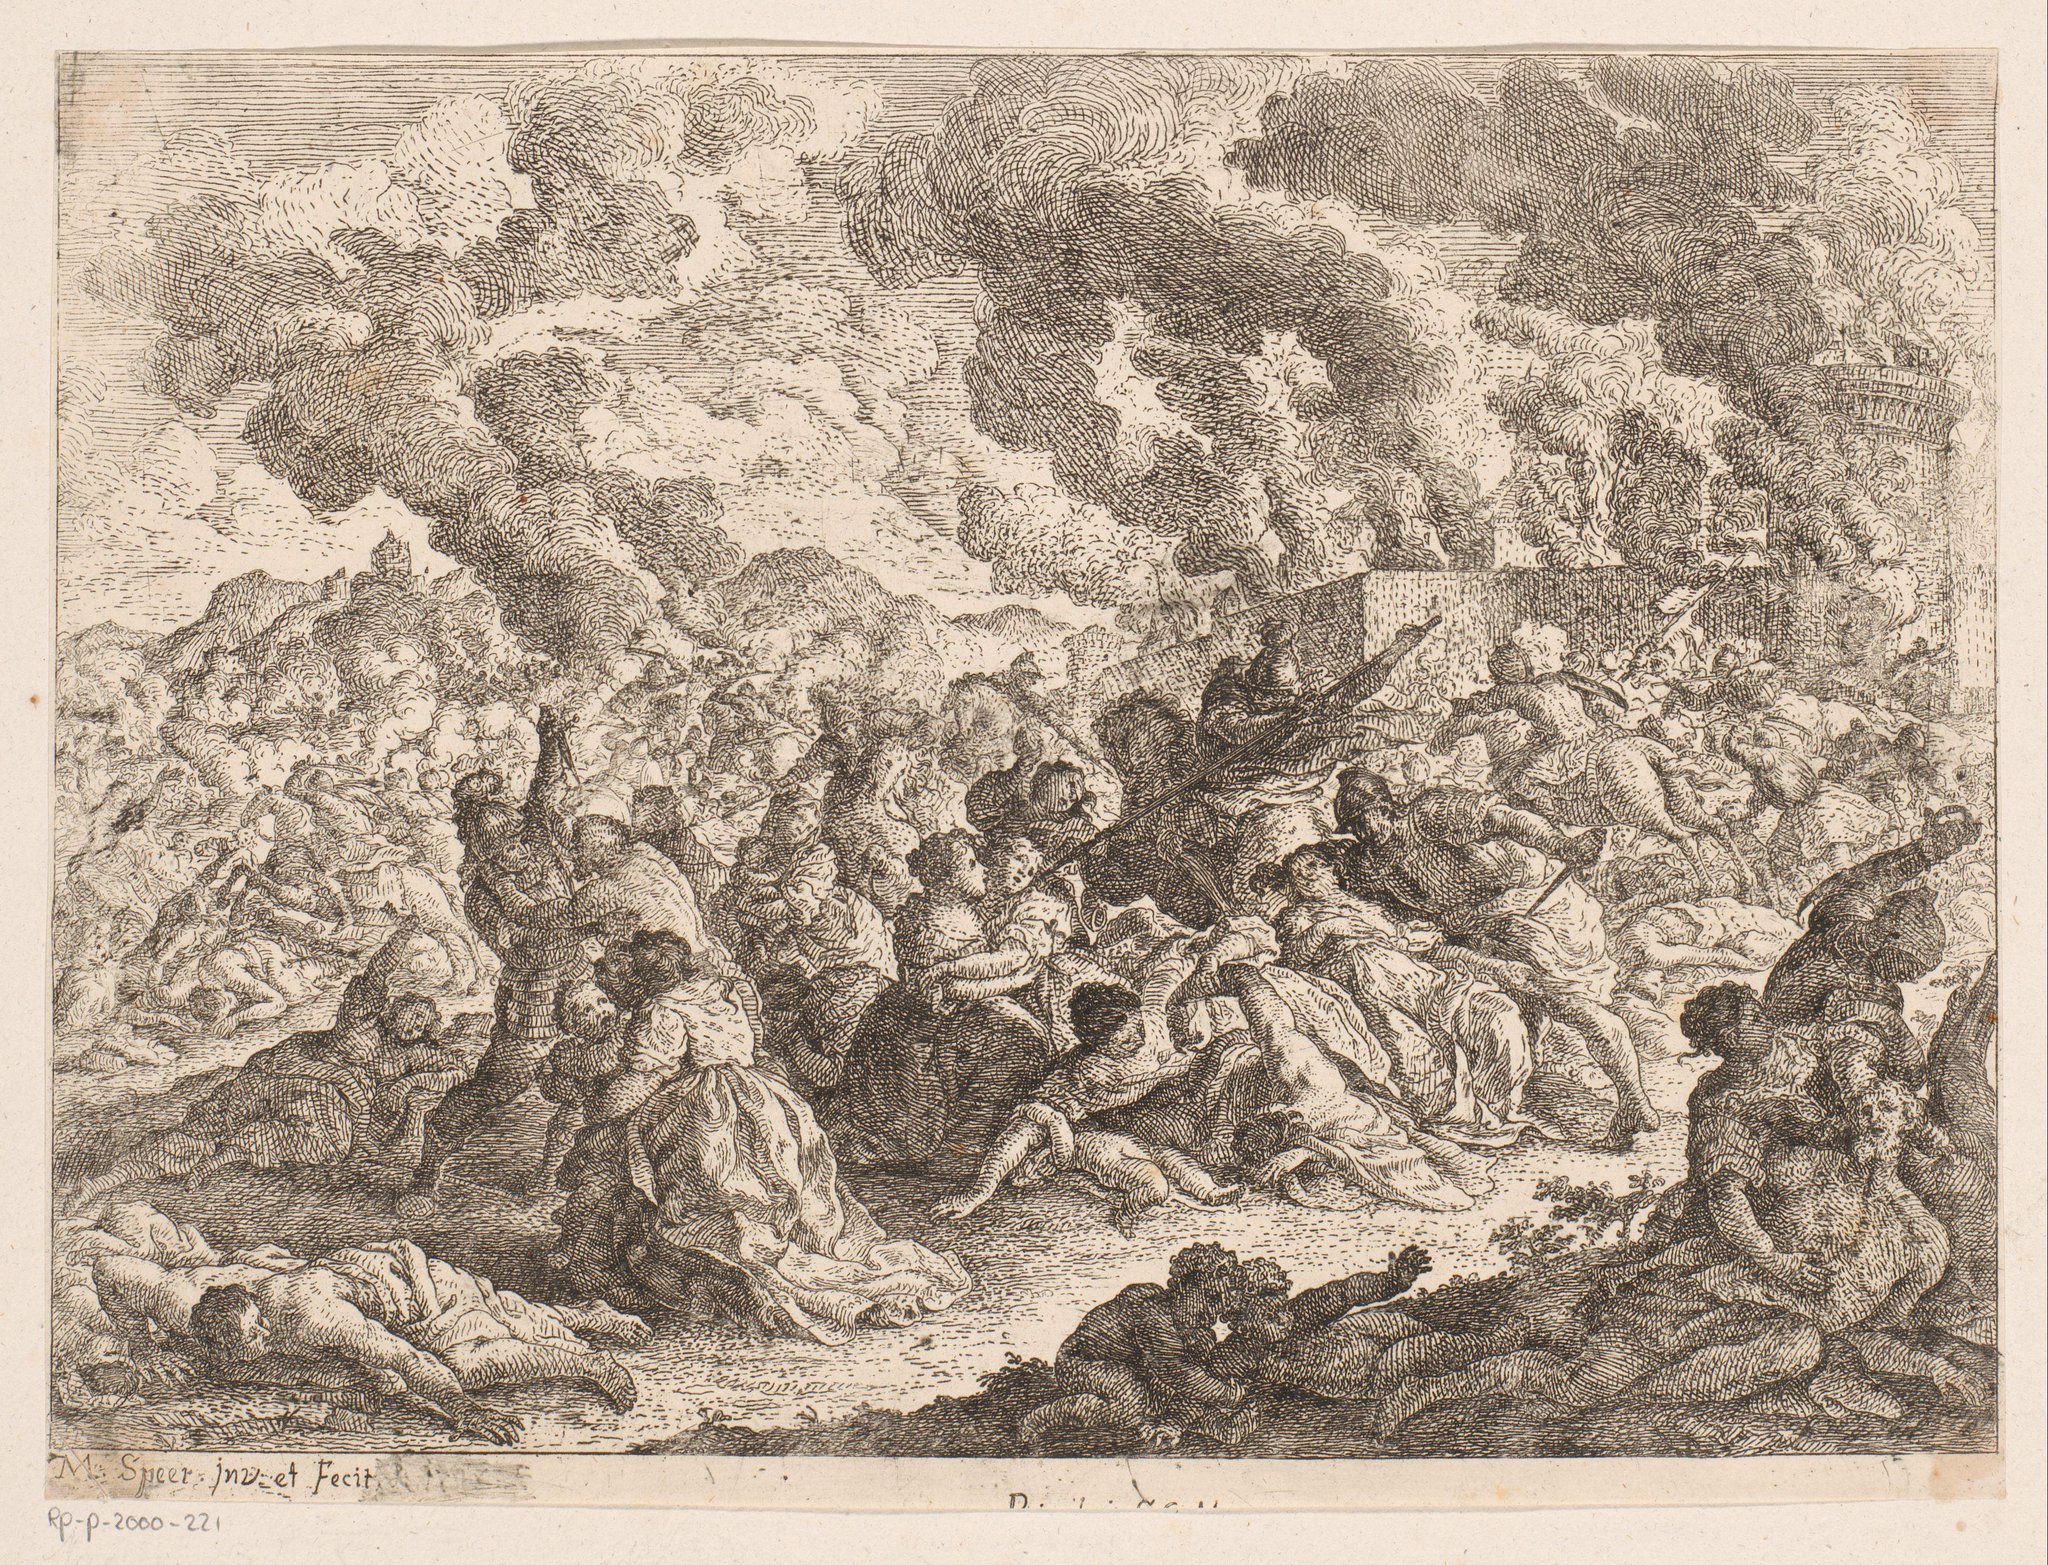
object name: print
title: Bloedbad voor de muren van een brandende stad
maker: martin speer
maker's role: painter, print maker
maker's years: 1702-1765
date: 1742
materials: paper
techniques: etching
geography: regensburg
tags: genocide, on fire, ablaze, war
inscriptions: collector's mark: Lugt 2760, collector's mark: Lugt 2228